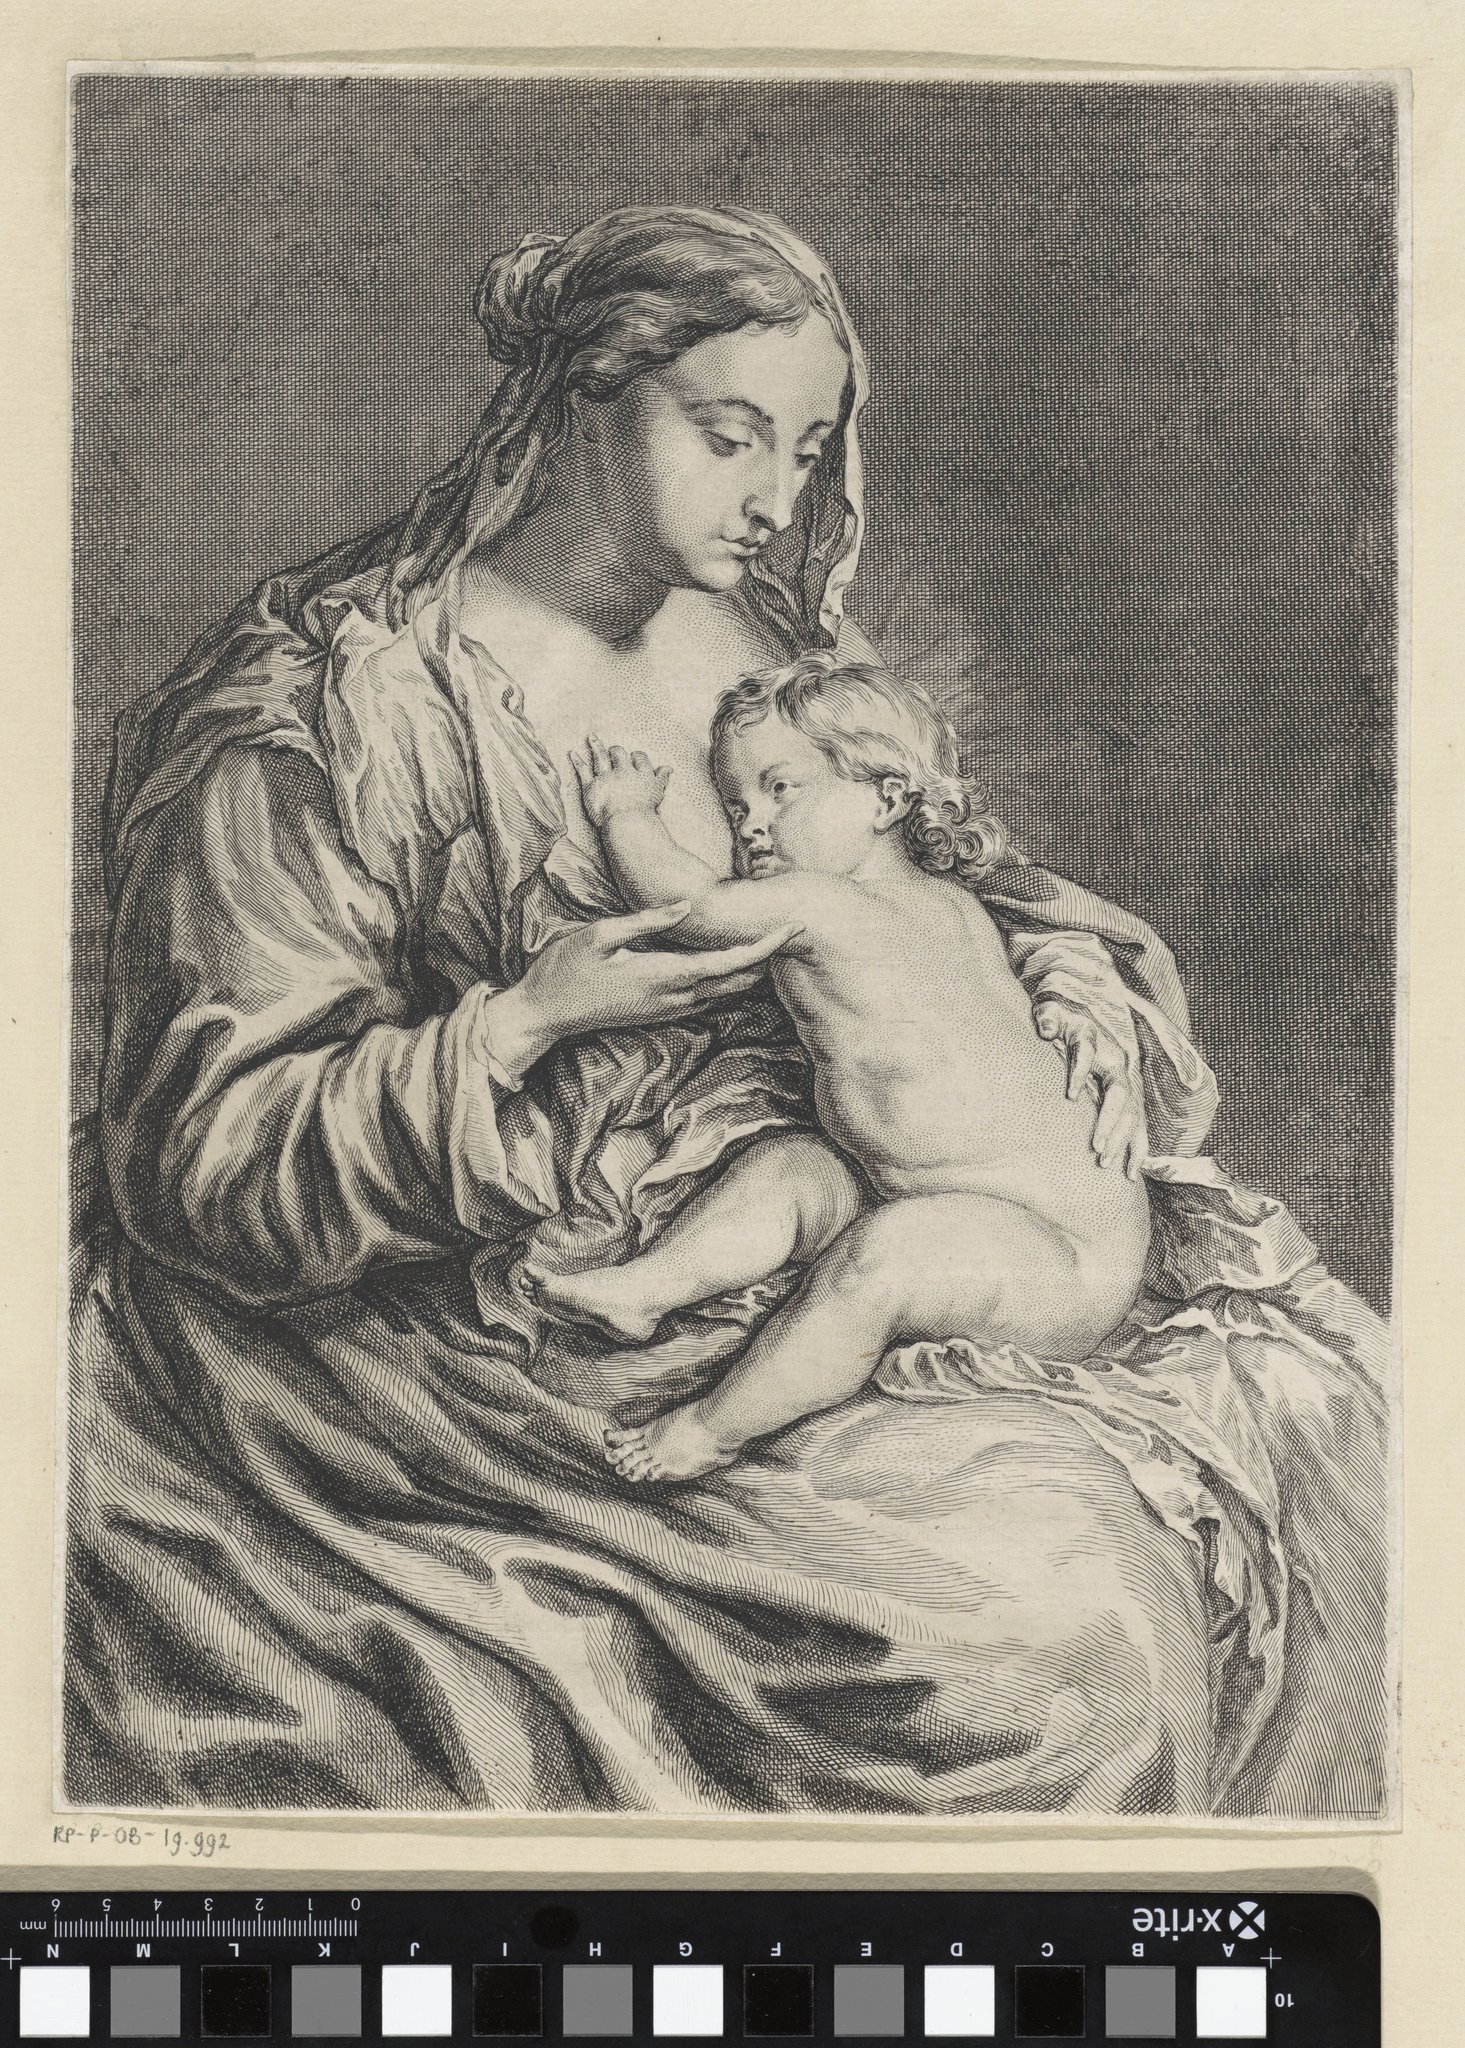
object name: print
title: Maria met het Christuskind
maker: jacob gole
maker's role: print maker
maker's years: 1660-1724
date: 1680-1724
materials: paper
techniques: engraving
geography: amsterdam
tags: madonna: mary sitting or enthroned, the christ-child in her lap (or in front of her bosom) (mary sometimes represented half-length)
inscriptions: collector's mark: Lugt 240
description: Het Christuskind zit bij Maria op schoot. Zijn hoofd en linkerhand rusten op haar borst.